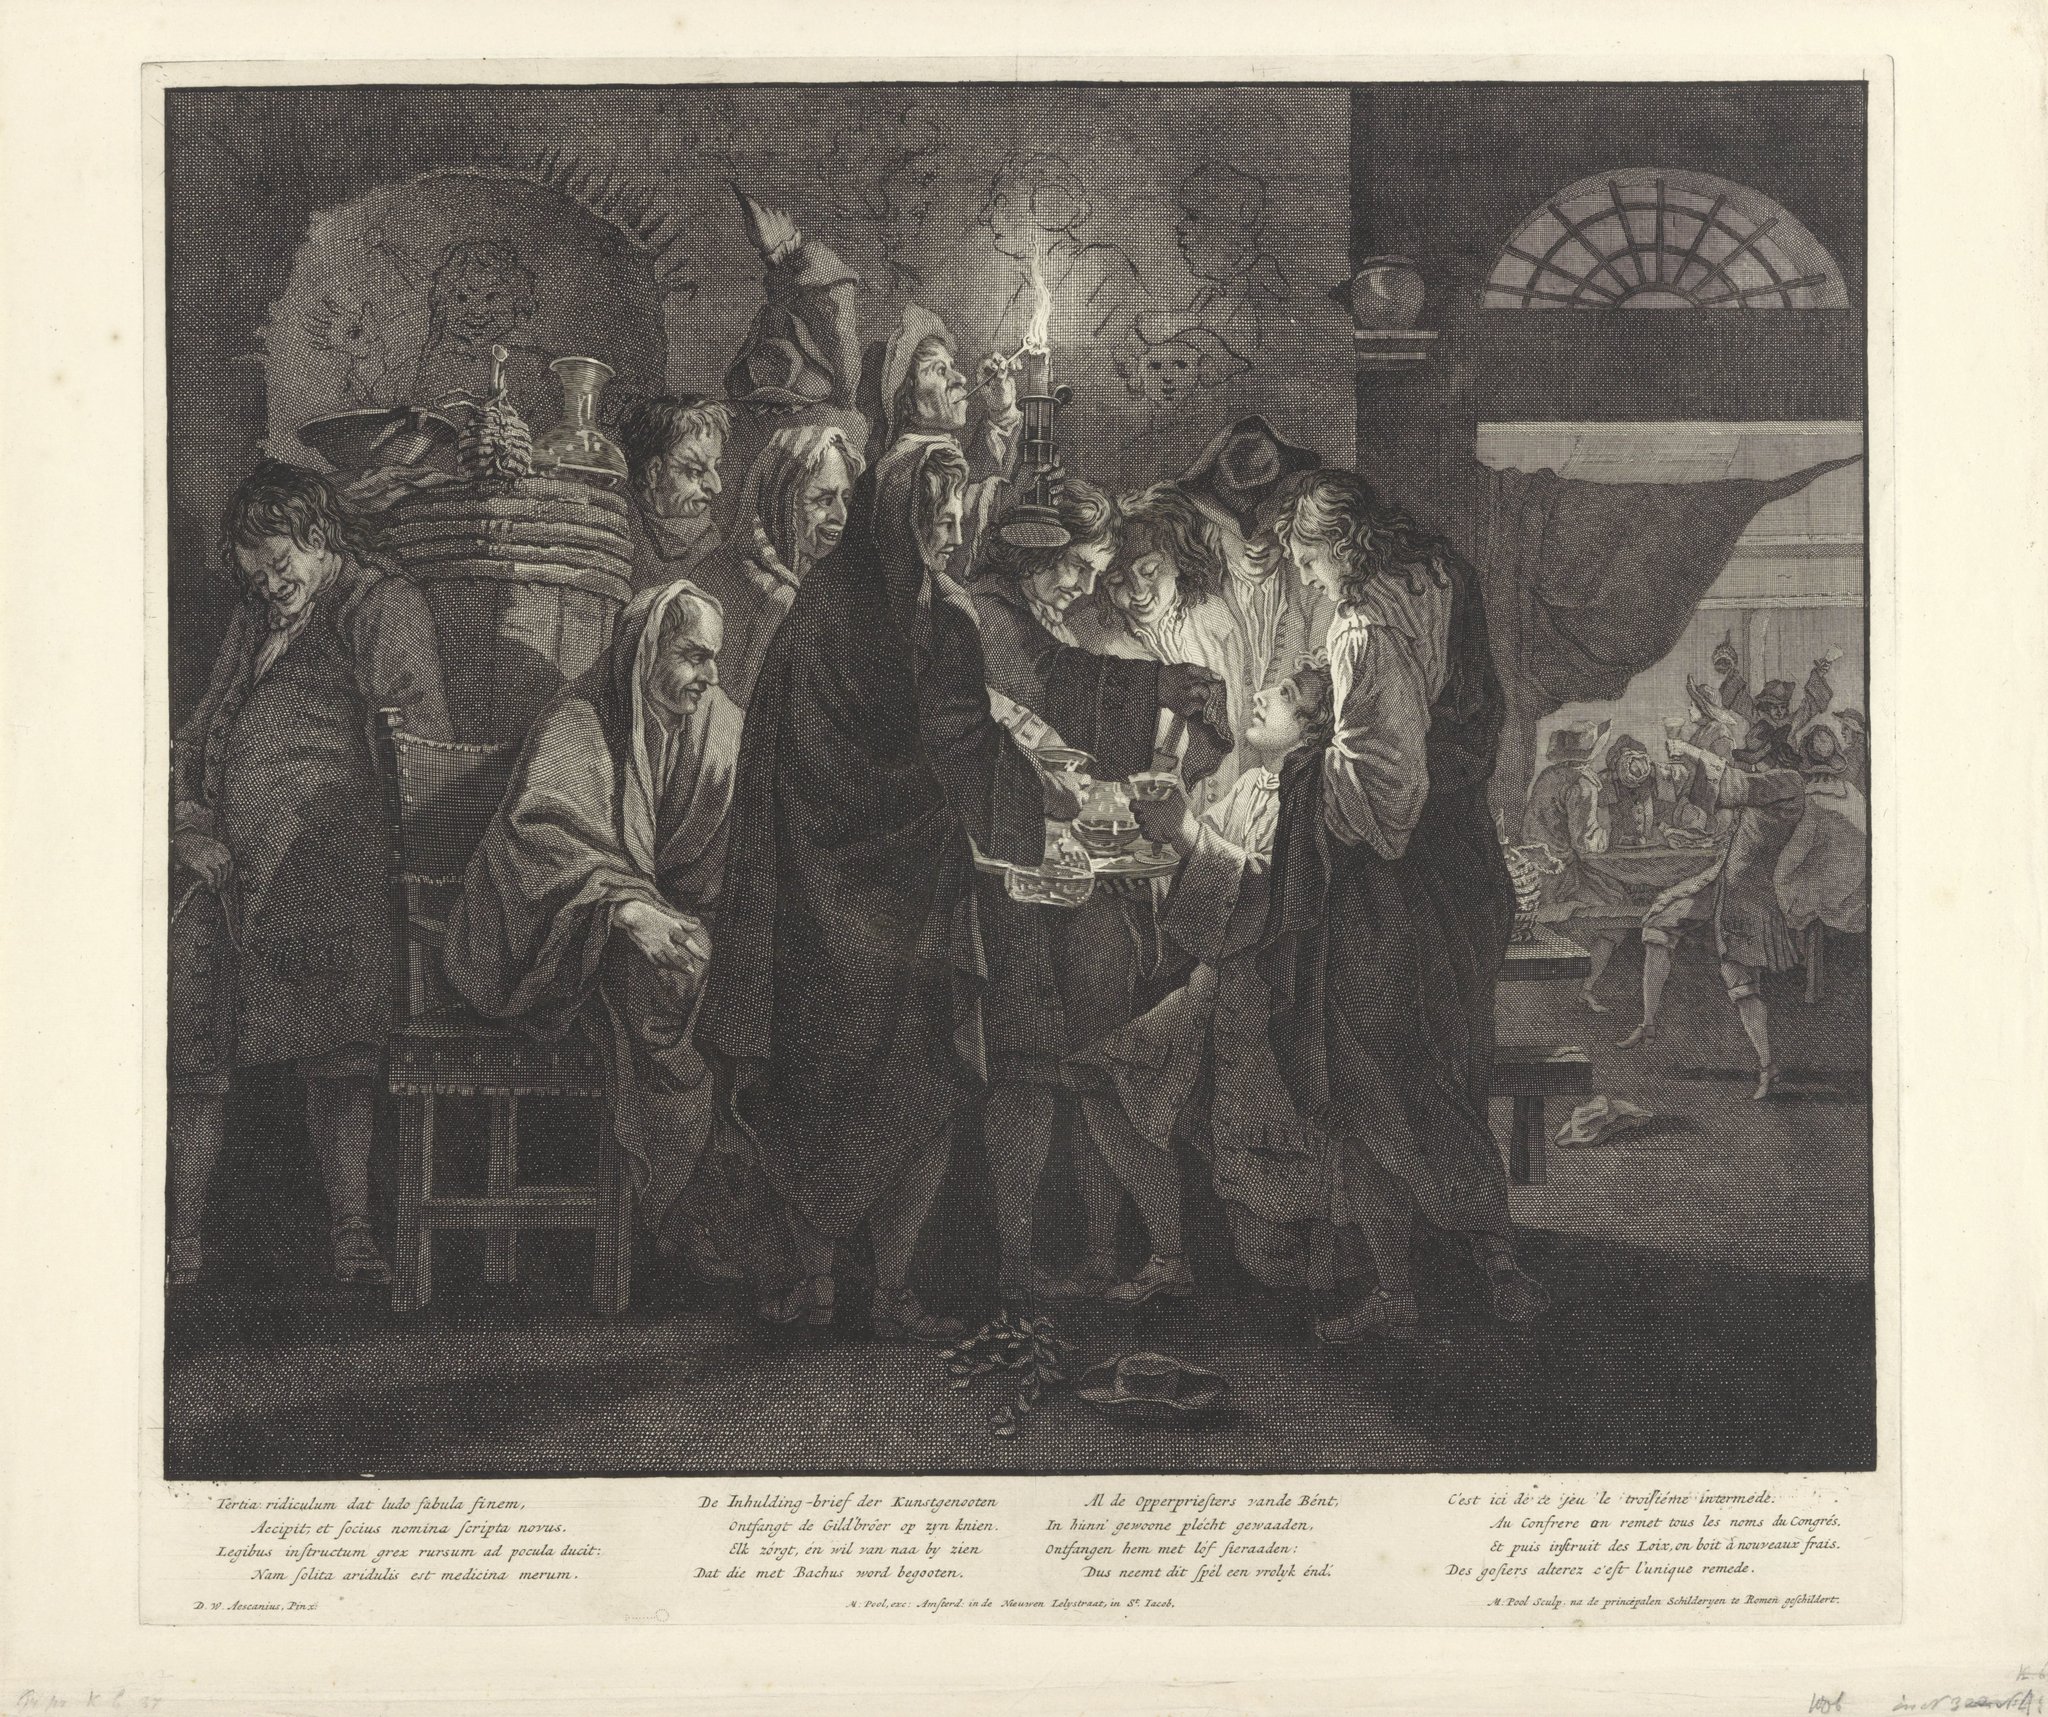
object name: print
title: Inwijding van een nieuwe Bentvueghel, ca. 1700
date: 1690-1710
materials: paper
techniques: engraving, etching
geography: amsterdam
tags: initiation (~ membership of a society), (professional) organization of artists, painter in non-work situation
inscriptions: collector's mark: Lugt 2228, collector's mark: Lugt 240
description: Inwijding van een nieuwe Bentvueghel, ca. 1700. Te midden van de groepsleden wordt in het duister een nieuw lid van de bentvogels, de groep van Nederlandse kunstenaars in Rome, met een ceremonie ingewijd met het knielend overhandigen van de bentbrief en de doop met wijn. Met getekende karikaturen aan de muur, op de achtergrond een drinkgelag.